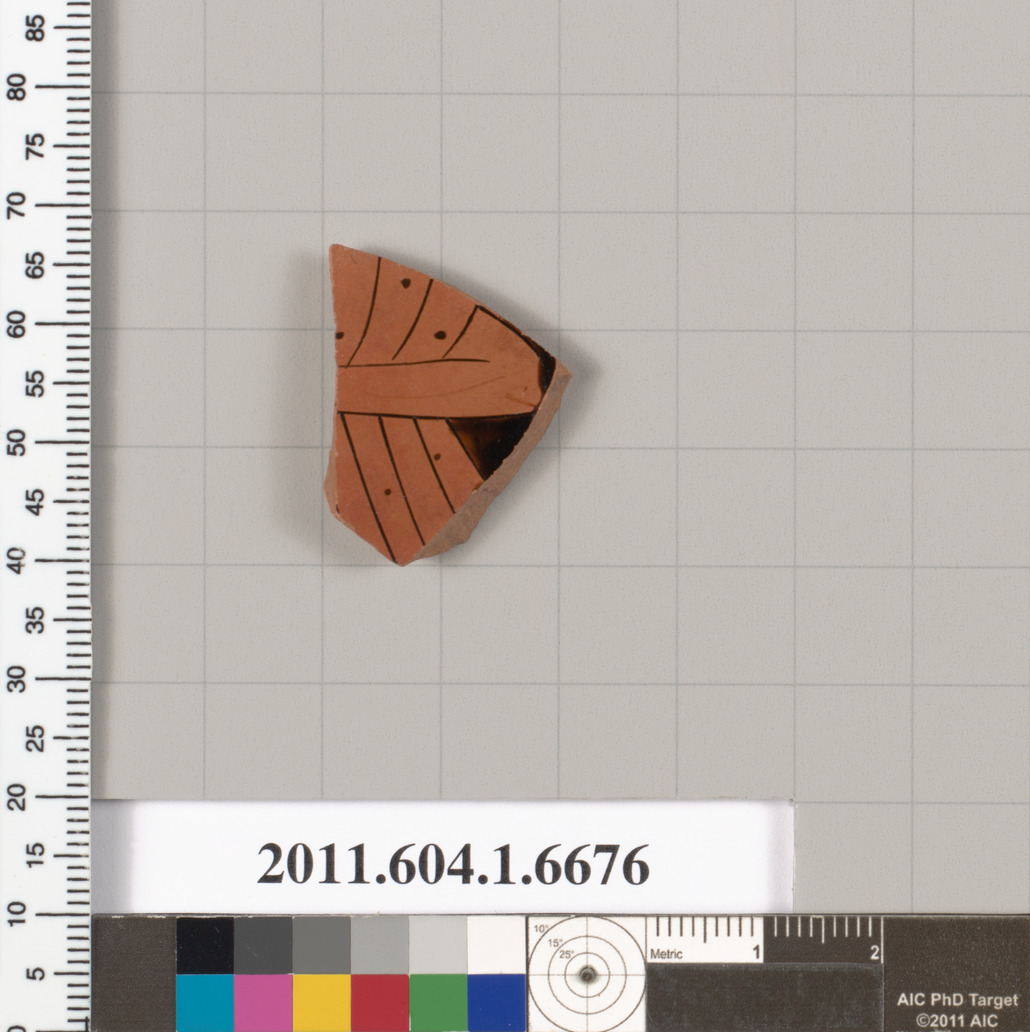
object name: kylix fragment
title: Terracotta fragment of a kylix (drinking cup)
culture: greek, attic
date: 490-470 BCE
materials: terracotta